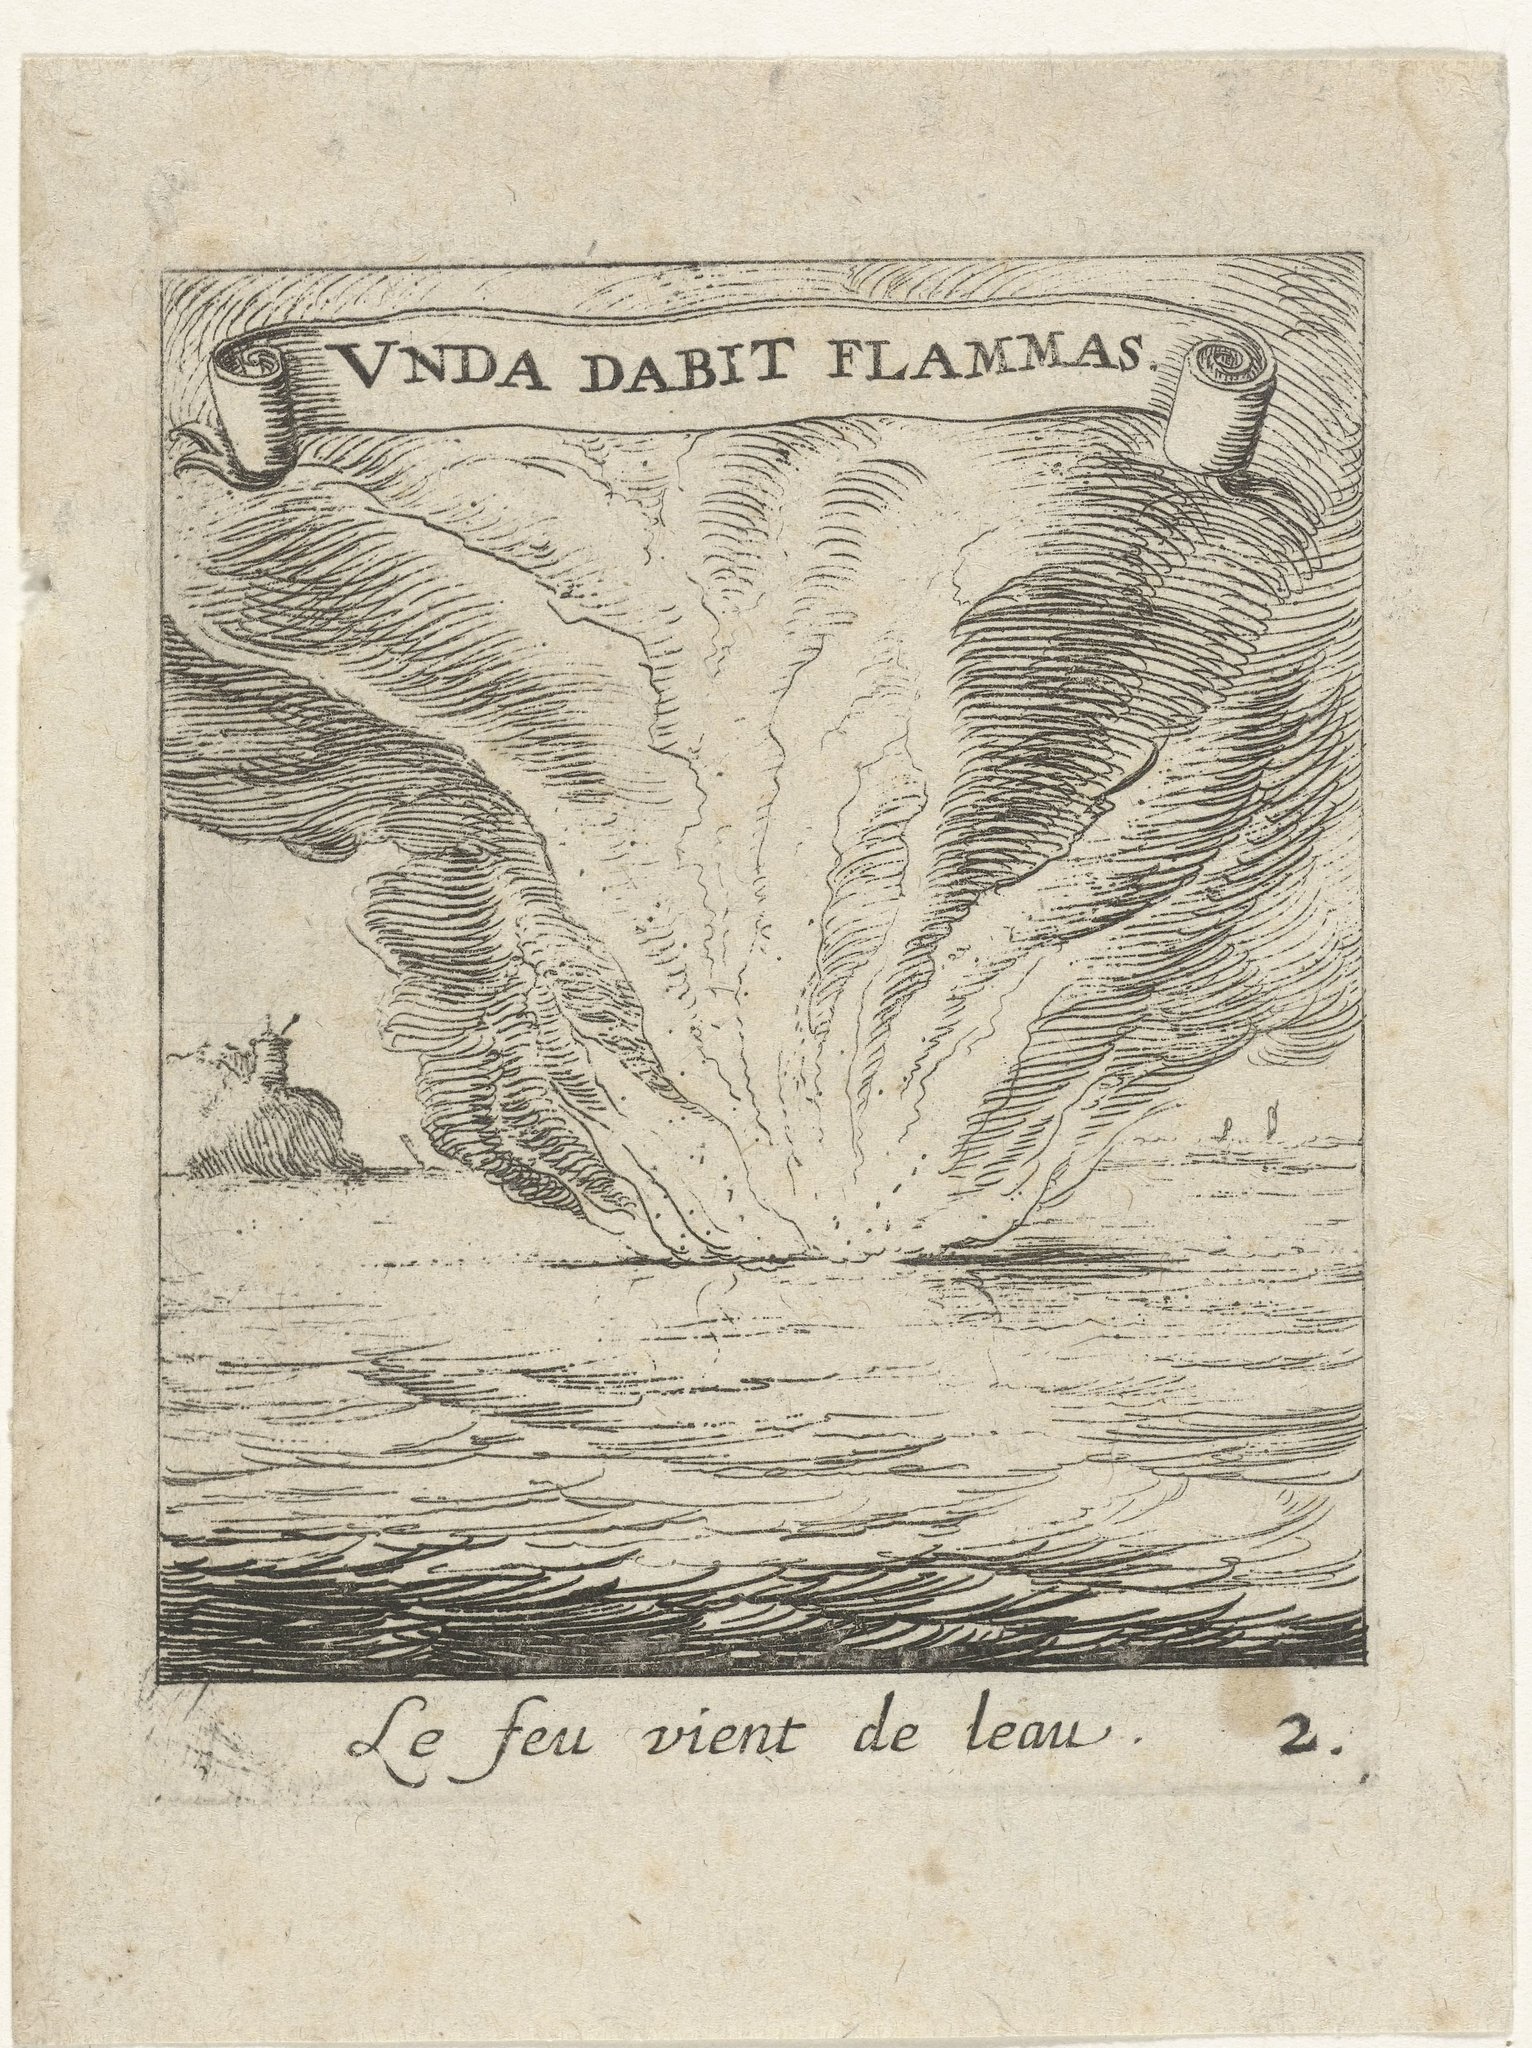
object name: print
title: Vurige uitbarsting in de zee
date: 1672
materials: paper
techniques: etching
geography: france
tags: qualities of love: first series (+ emblematical representation of concept)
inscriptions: collector's mark: Lugt 2166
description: Hoge vlammen en rookwolken boven het water. Op een banderol een devies in Latijn en een onderschrift in Frans, beide over de liefde.